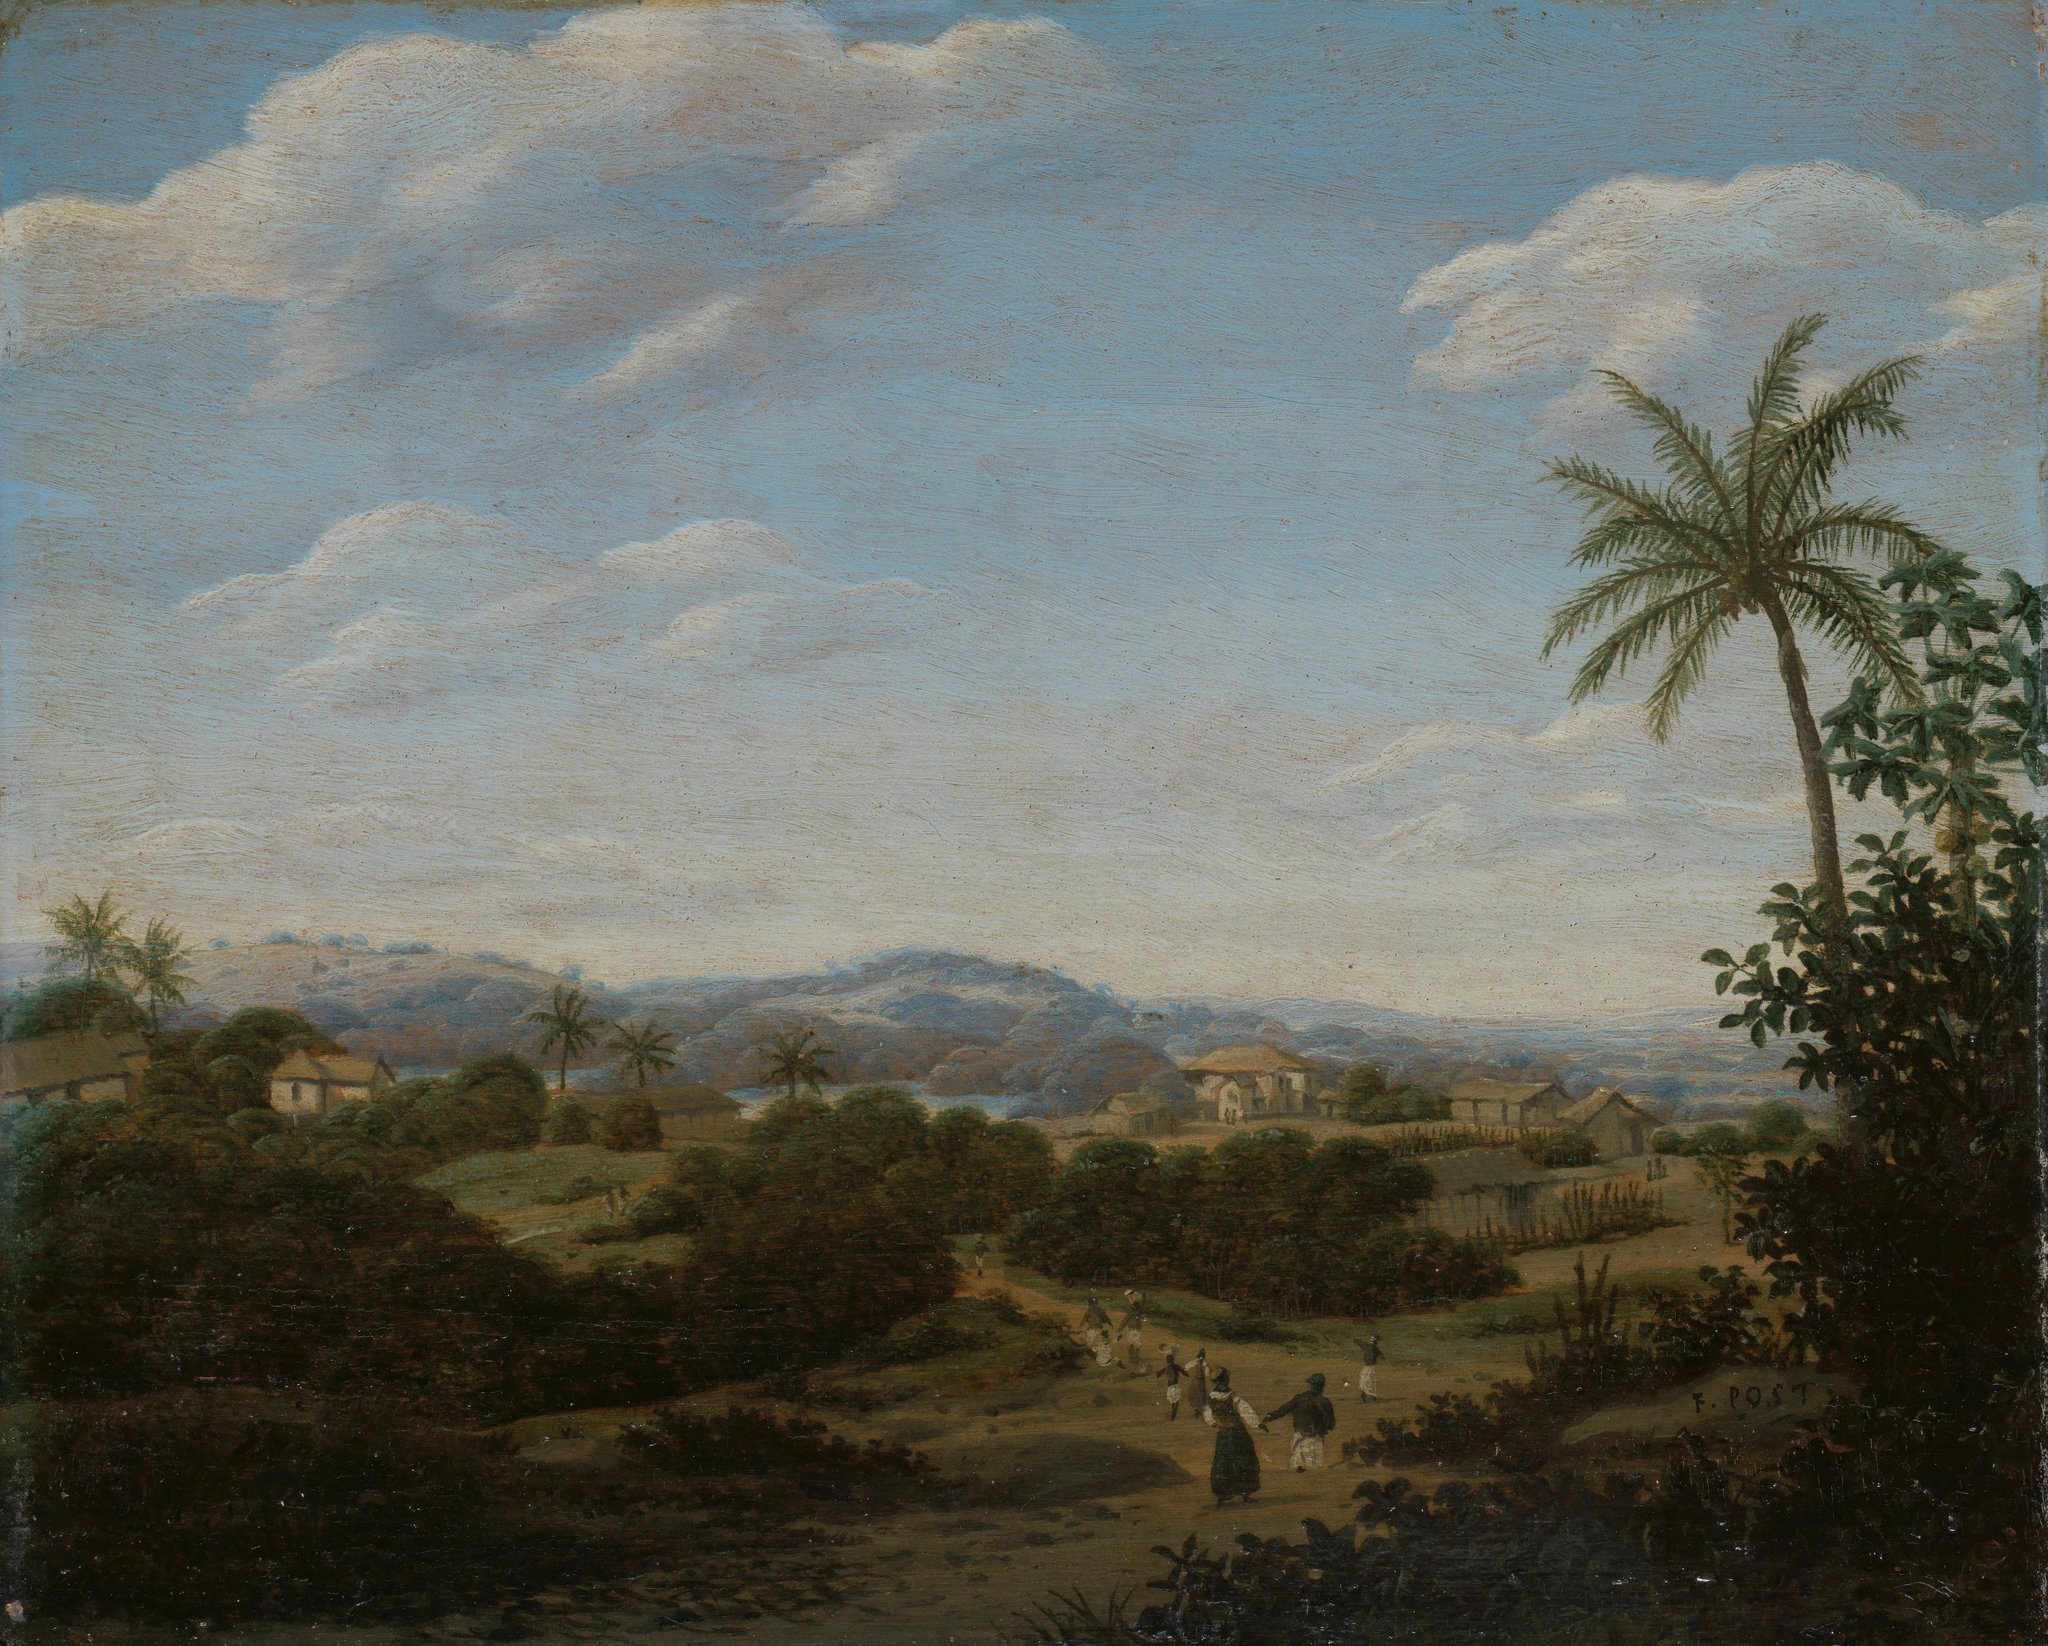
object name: painting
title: Brazilian landscape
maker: frans jansz post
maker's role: painter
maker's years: 1612-1680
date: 1670-1680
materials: oil, panel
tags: landscapes in tropical and sub-tropical regions, brasil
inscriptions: signature: ‘F. Post’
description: Frans Post travelled to Brazil in 1637 as part of the entourage of Governor Johan Maurits of NassauSiegen. Once there, he made paintings and drawings of the landscape. On the artist’s return to the Dutch Republic in 1644, he continued making romanticized ‘Brazilian’ landscapes, like this little panel.